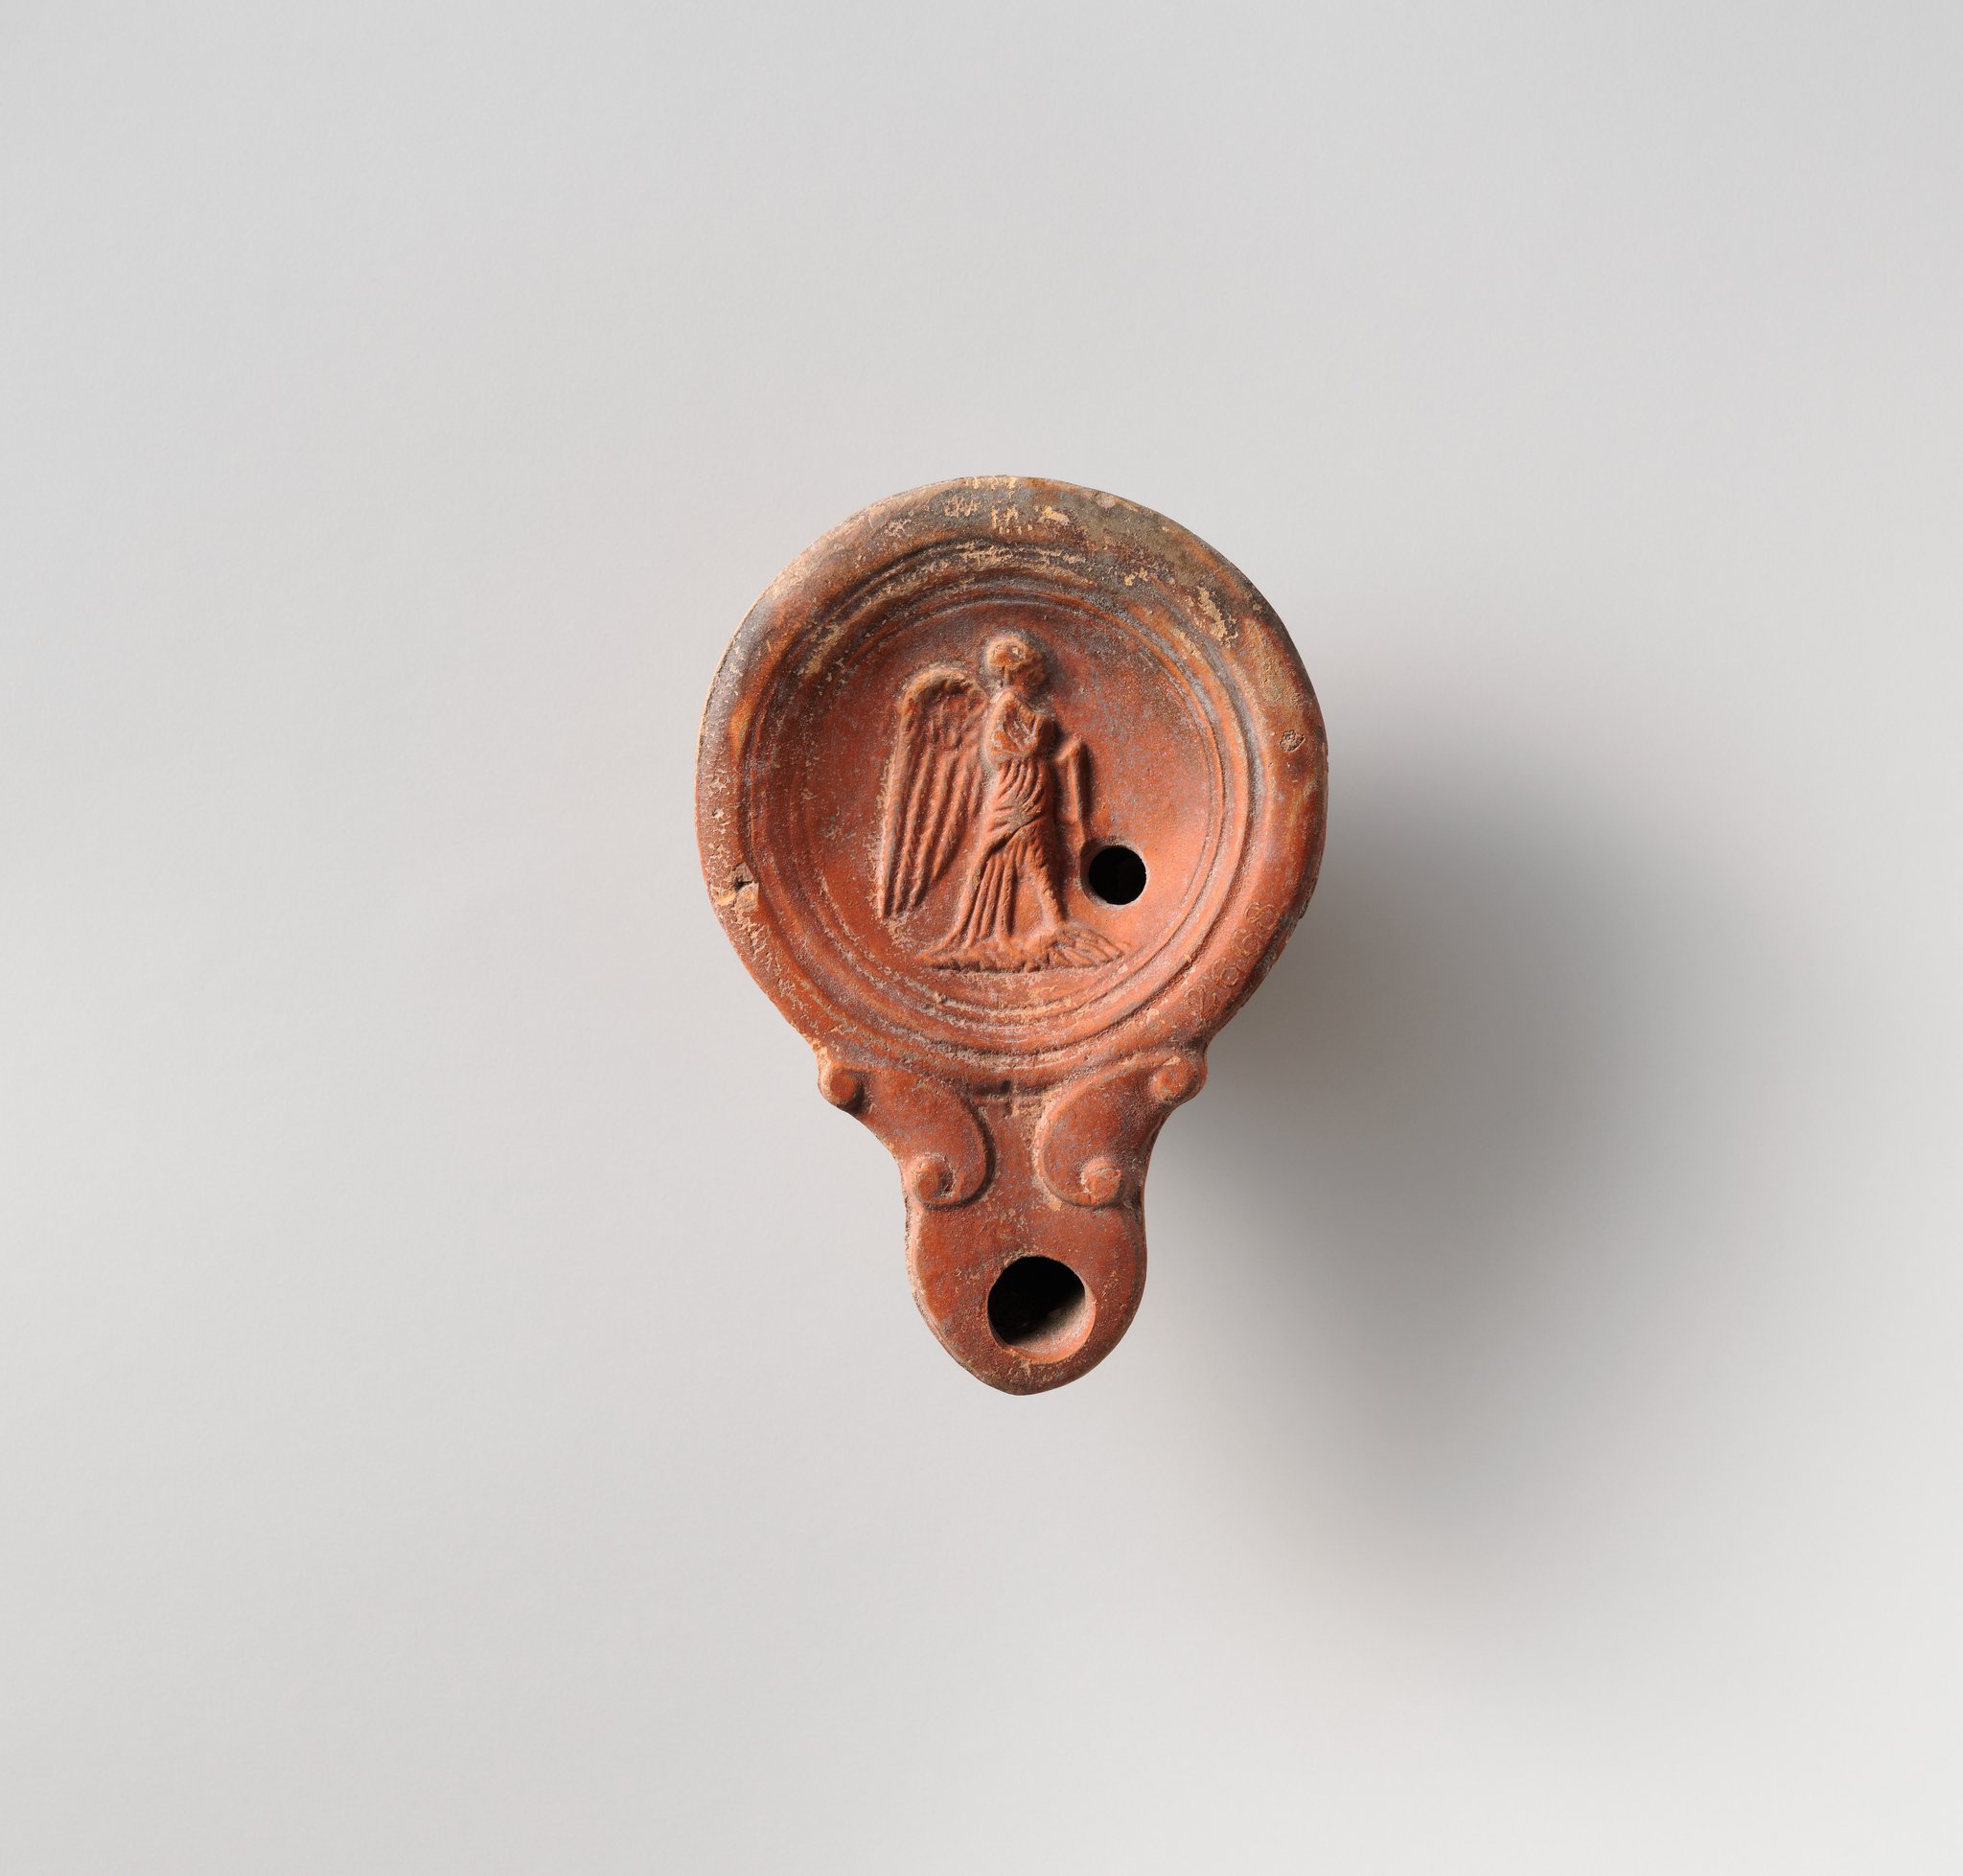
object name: lamp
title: Terracotta oil lamp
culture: roman, cypriot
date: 40-100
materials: terracotta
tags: sirens